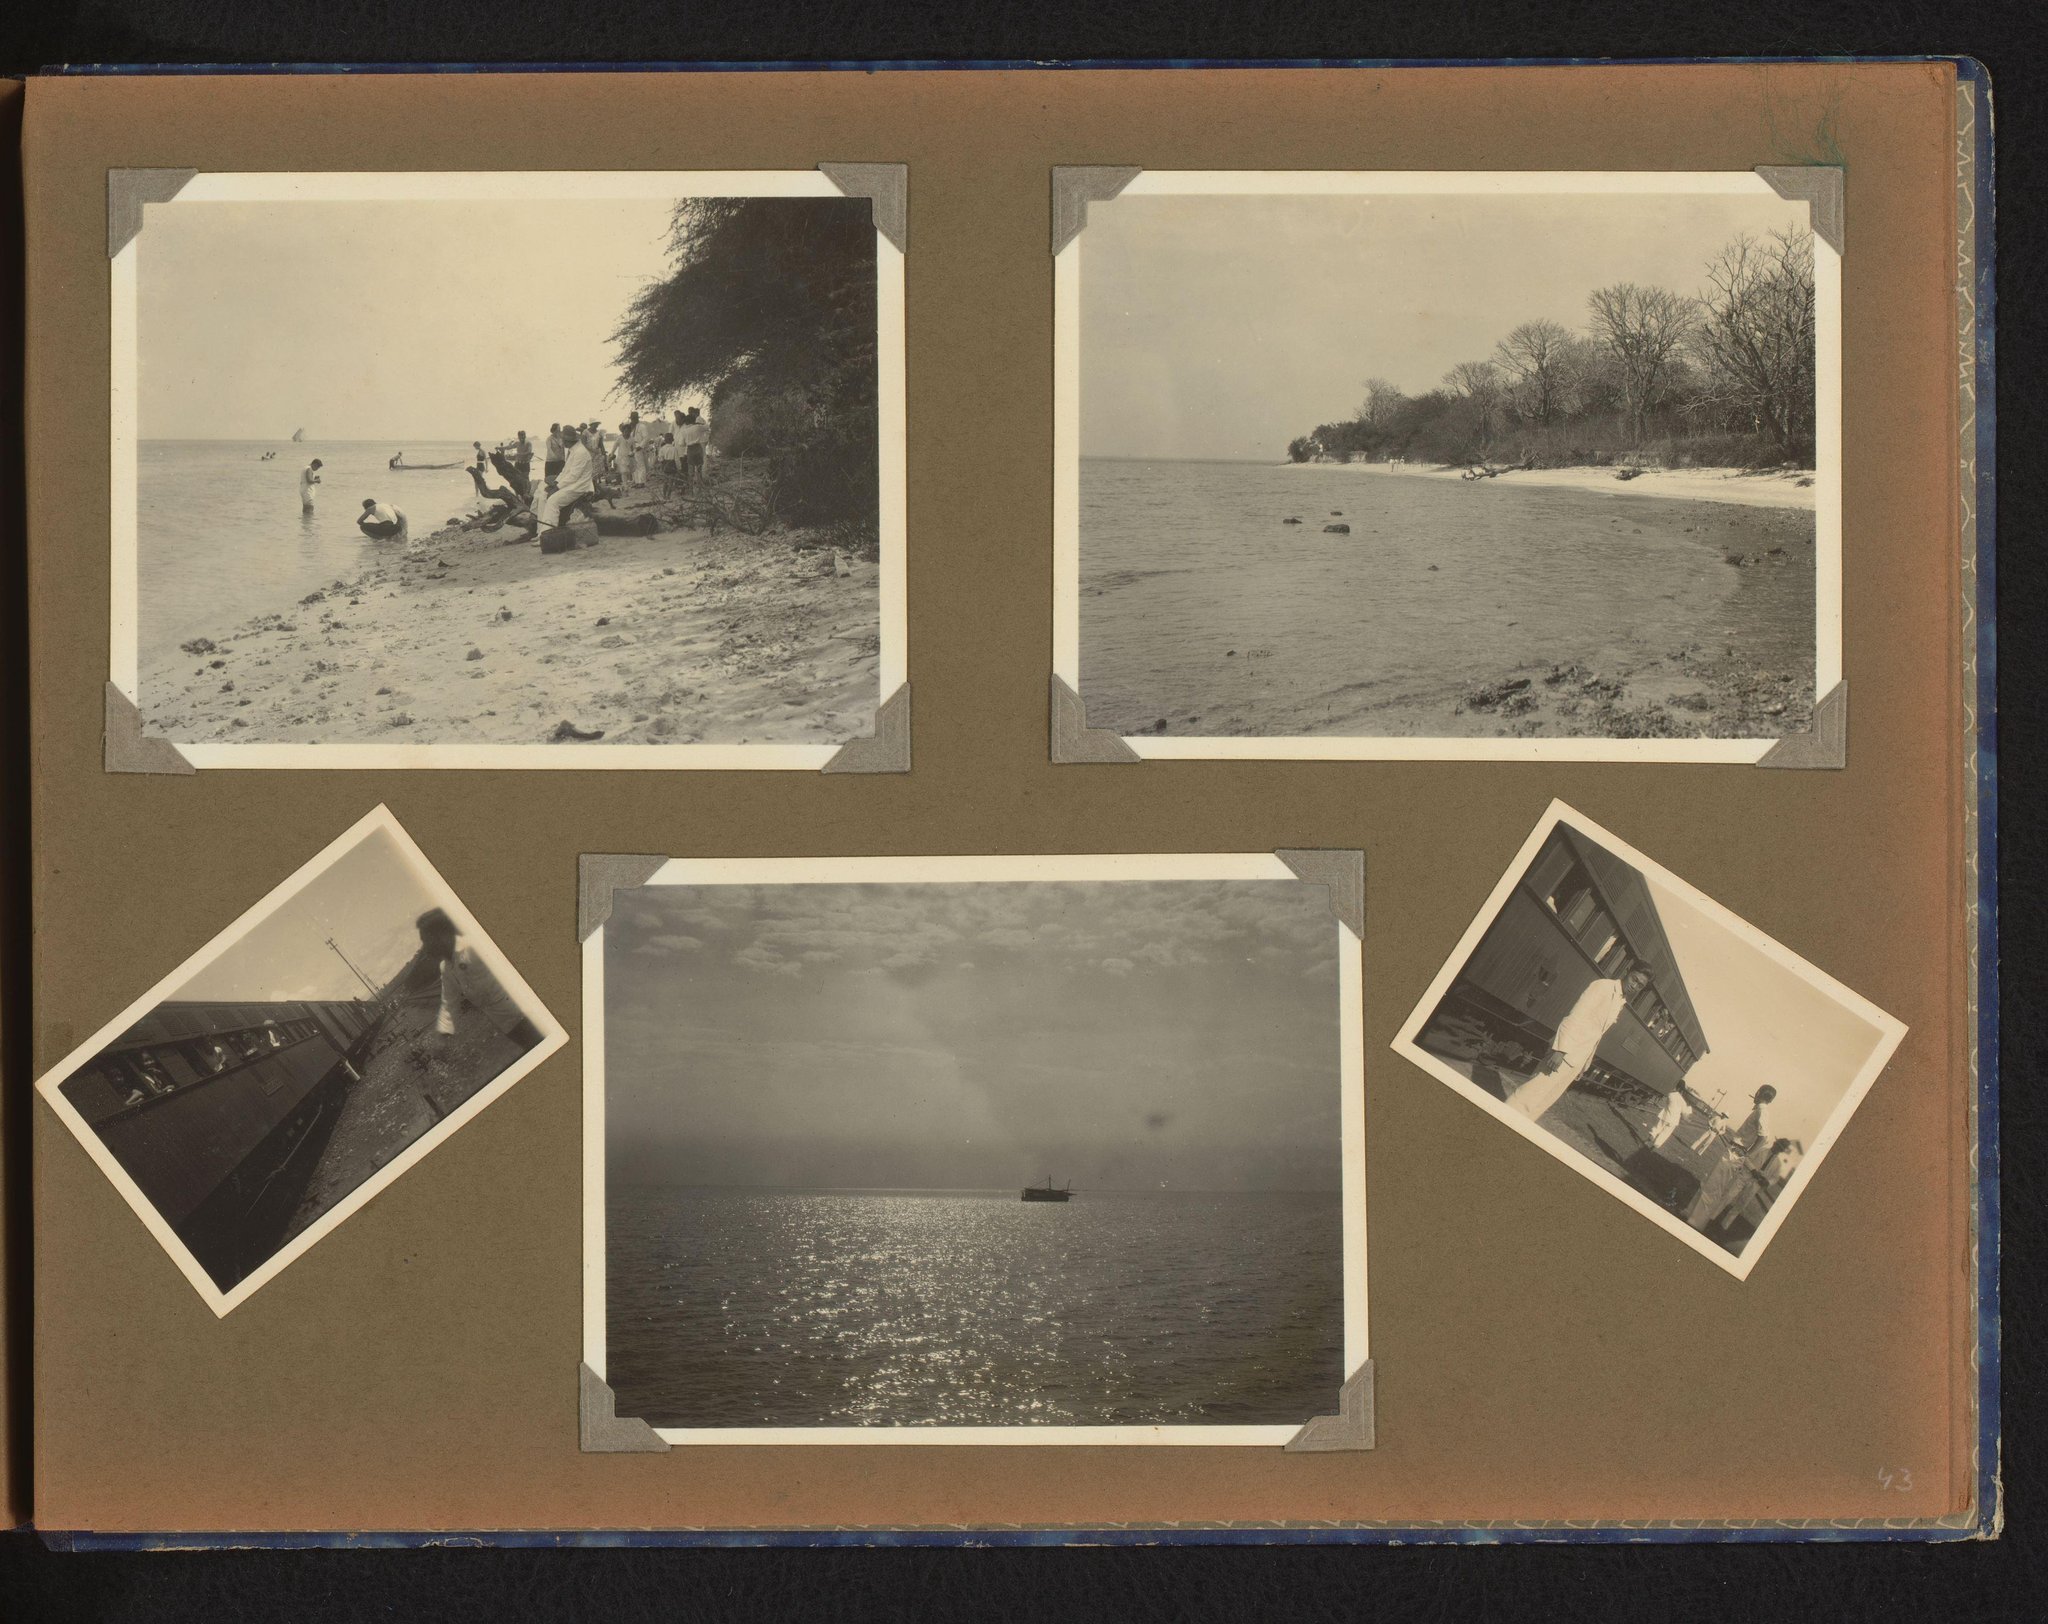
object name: photograph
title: Uitje naar de kust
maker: Anonymous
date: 1935-1936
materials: cardboard, photographic support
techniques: gelatin silver print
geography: indonesia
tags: passenger train, outing, pleasure trip, indonesia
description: Albumblad met vijf foto's aan de kust en van een treinreis, reis door een groep jongen, Mogelijk gaat het om een excursie door leden van de Chung Hsiok vereniging. Onderdeel van een familiealbum van een Chinees-Indische familie in Weltevreden, ca. 1935.